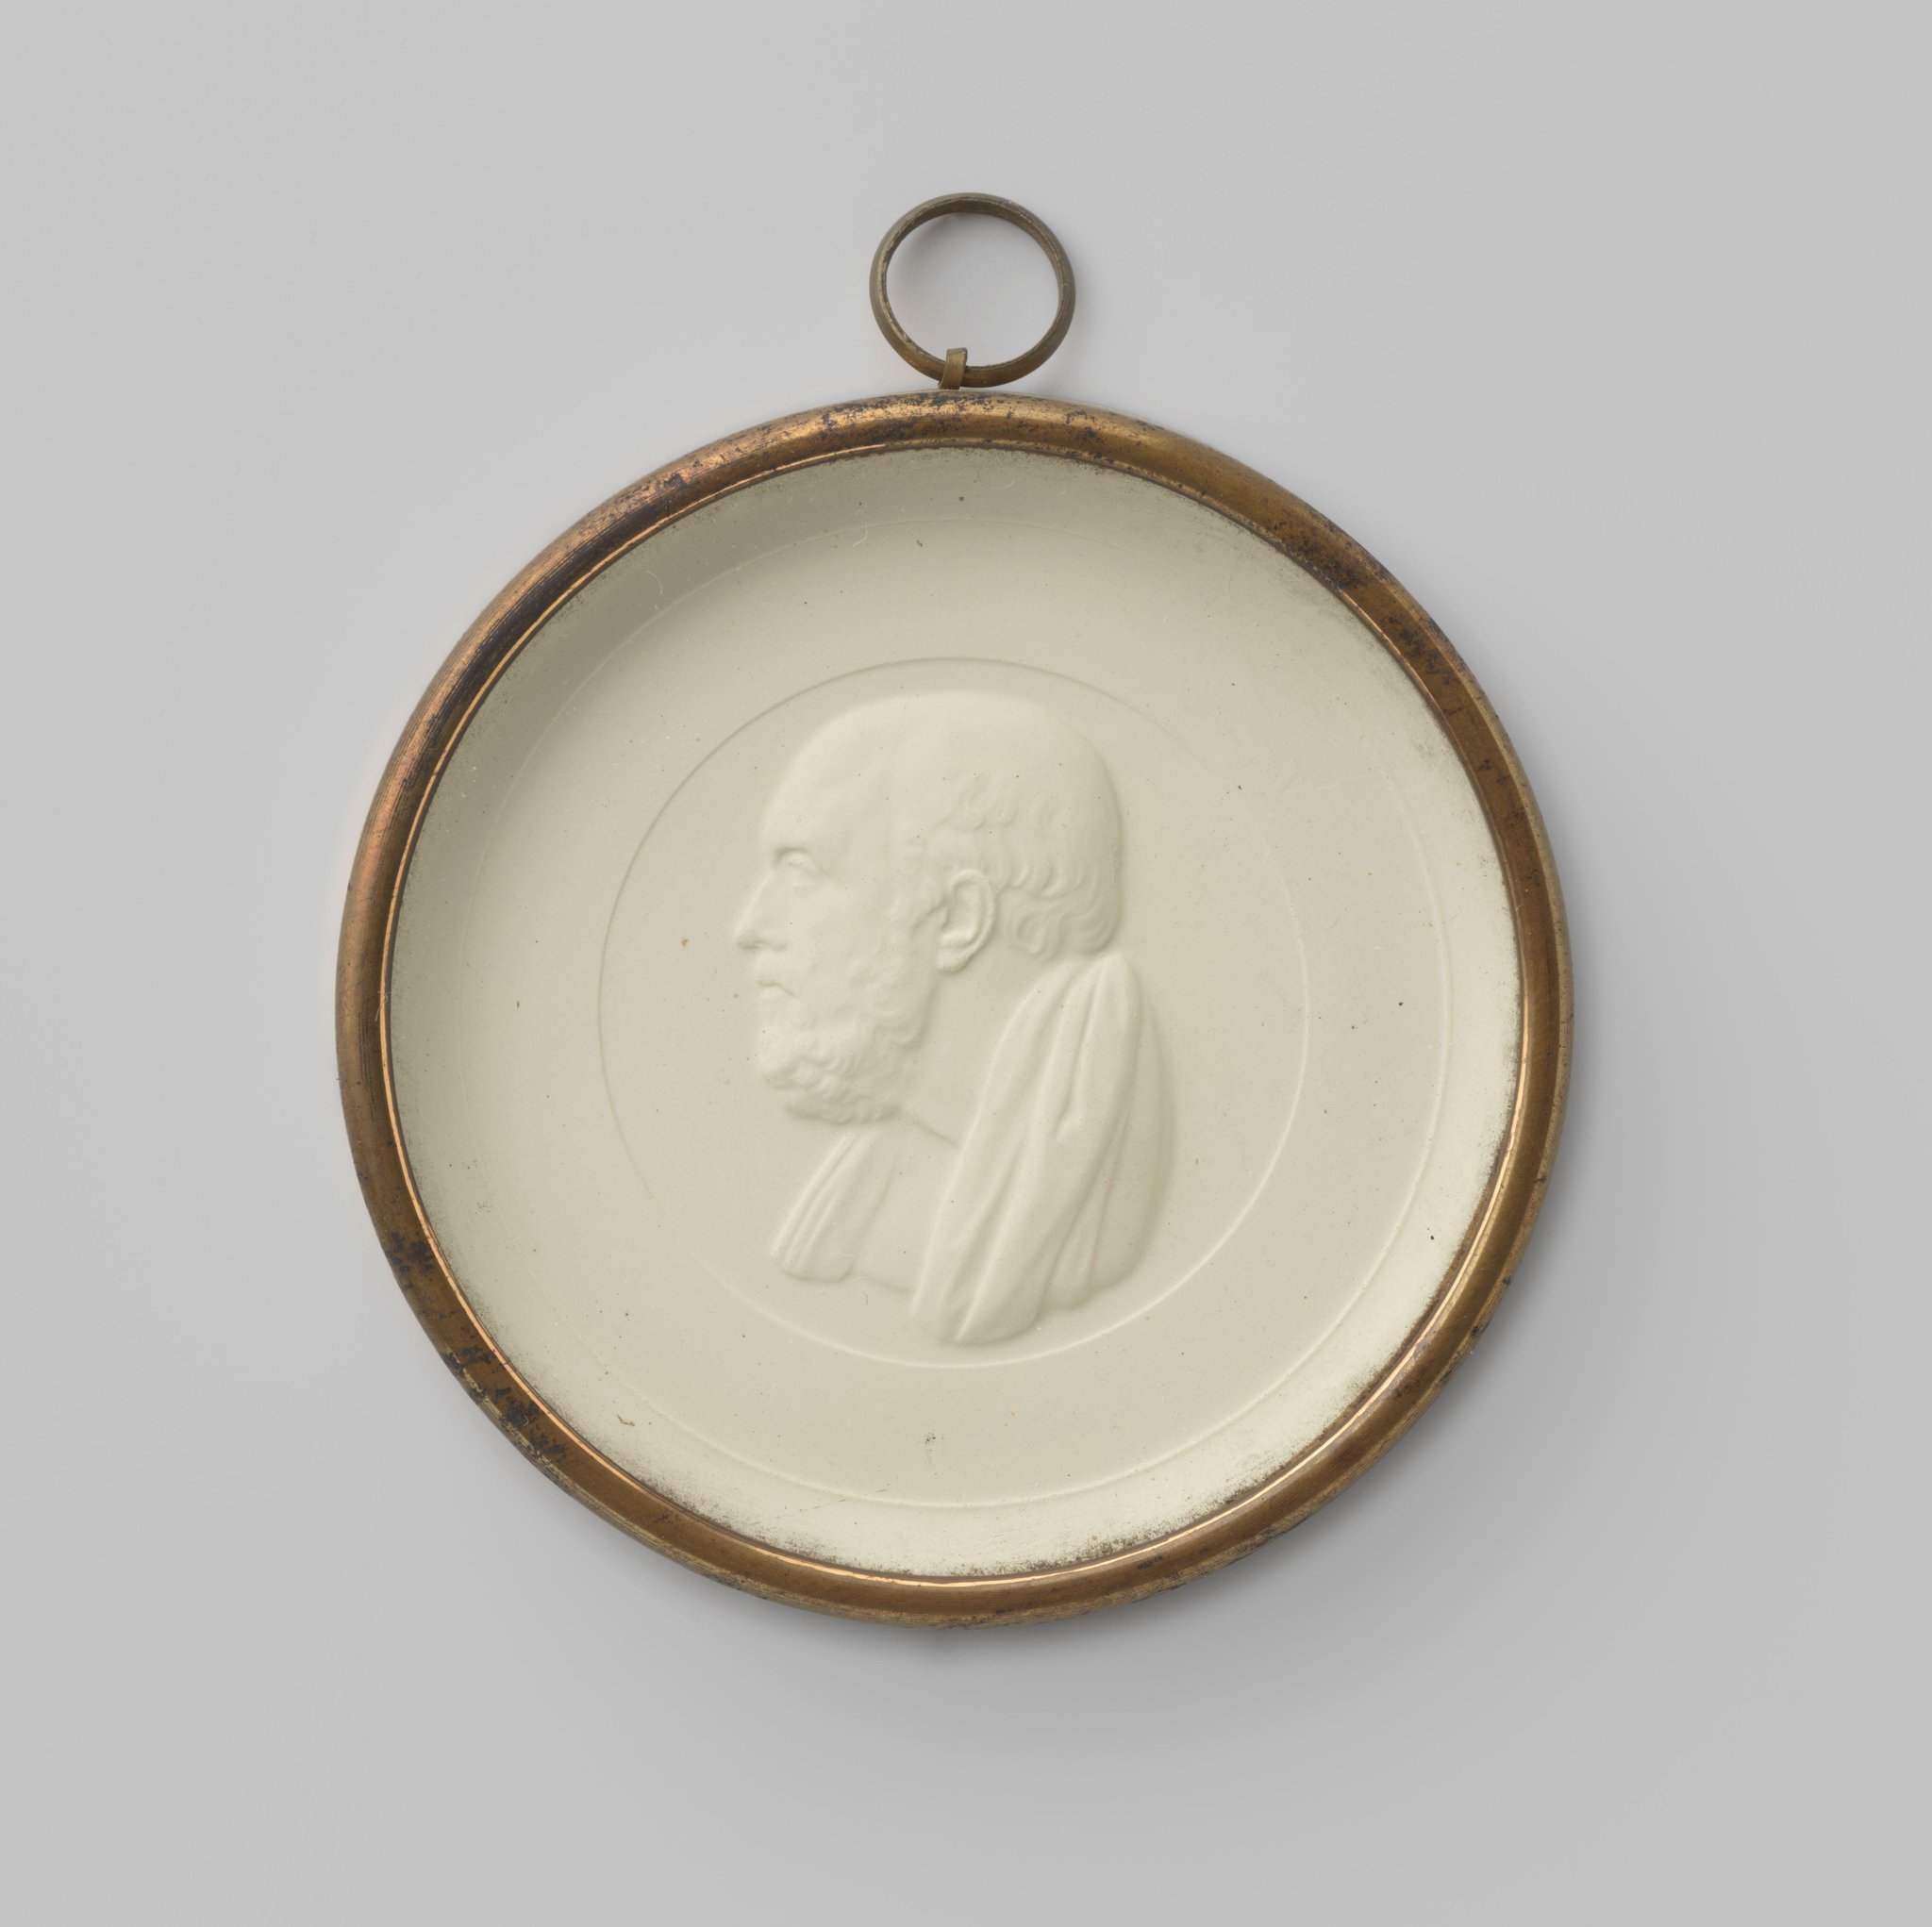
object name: locket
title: Hippocrates, Grieks medicus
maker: gottfried eichler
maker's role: draughtsman, painter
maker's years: 1677-1757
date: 1687-1757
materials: brass, glass, gypsum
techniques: casting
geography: berlin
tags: hippocrates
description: Eenzijdig medaillon in messing ring achter glas aan draagoog en draagring. Voorzijde: borststuk man naar links. Keerzijde: etiket met opschrift.